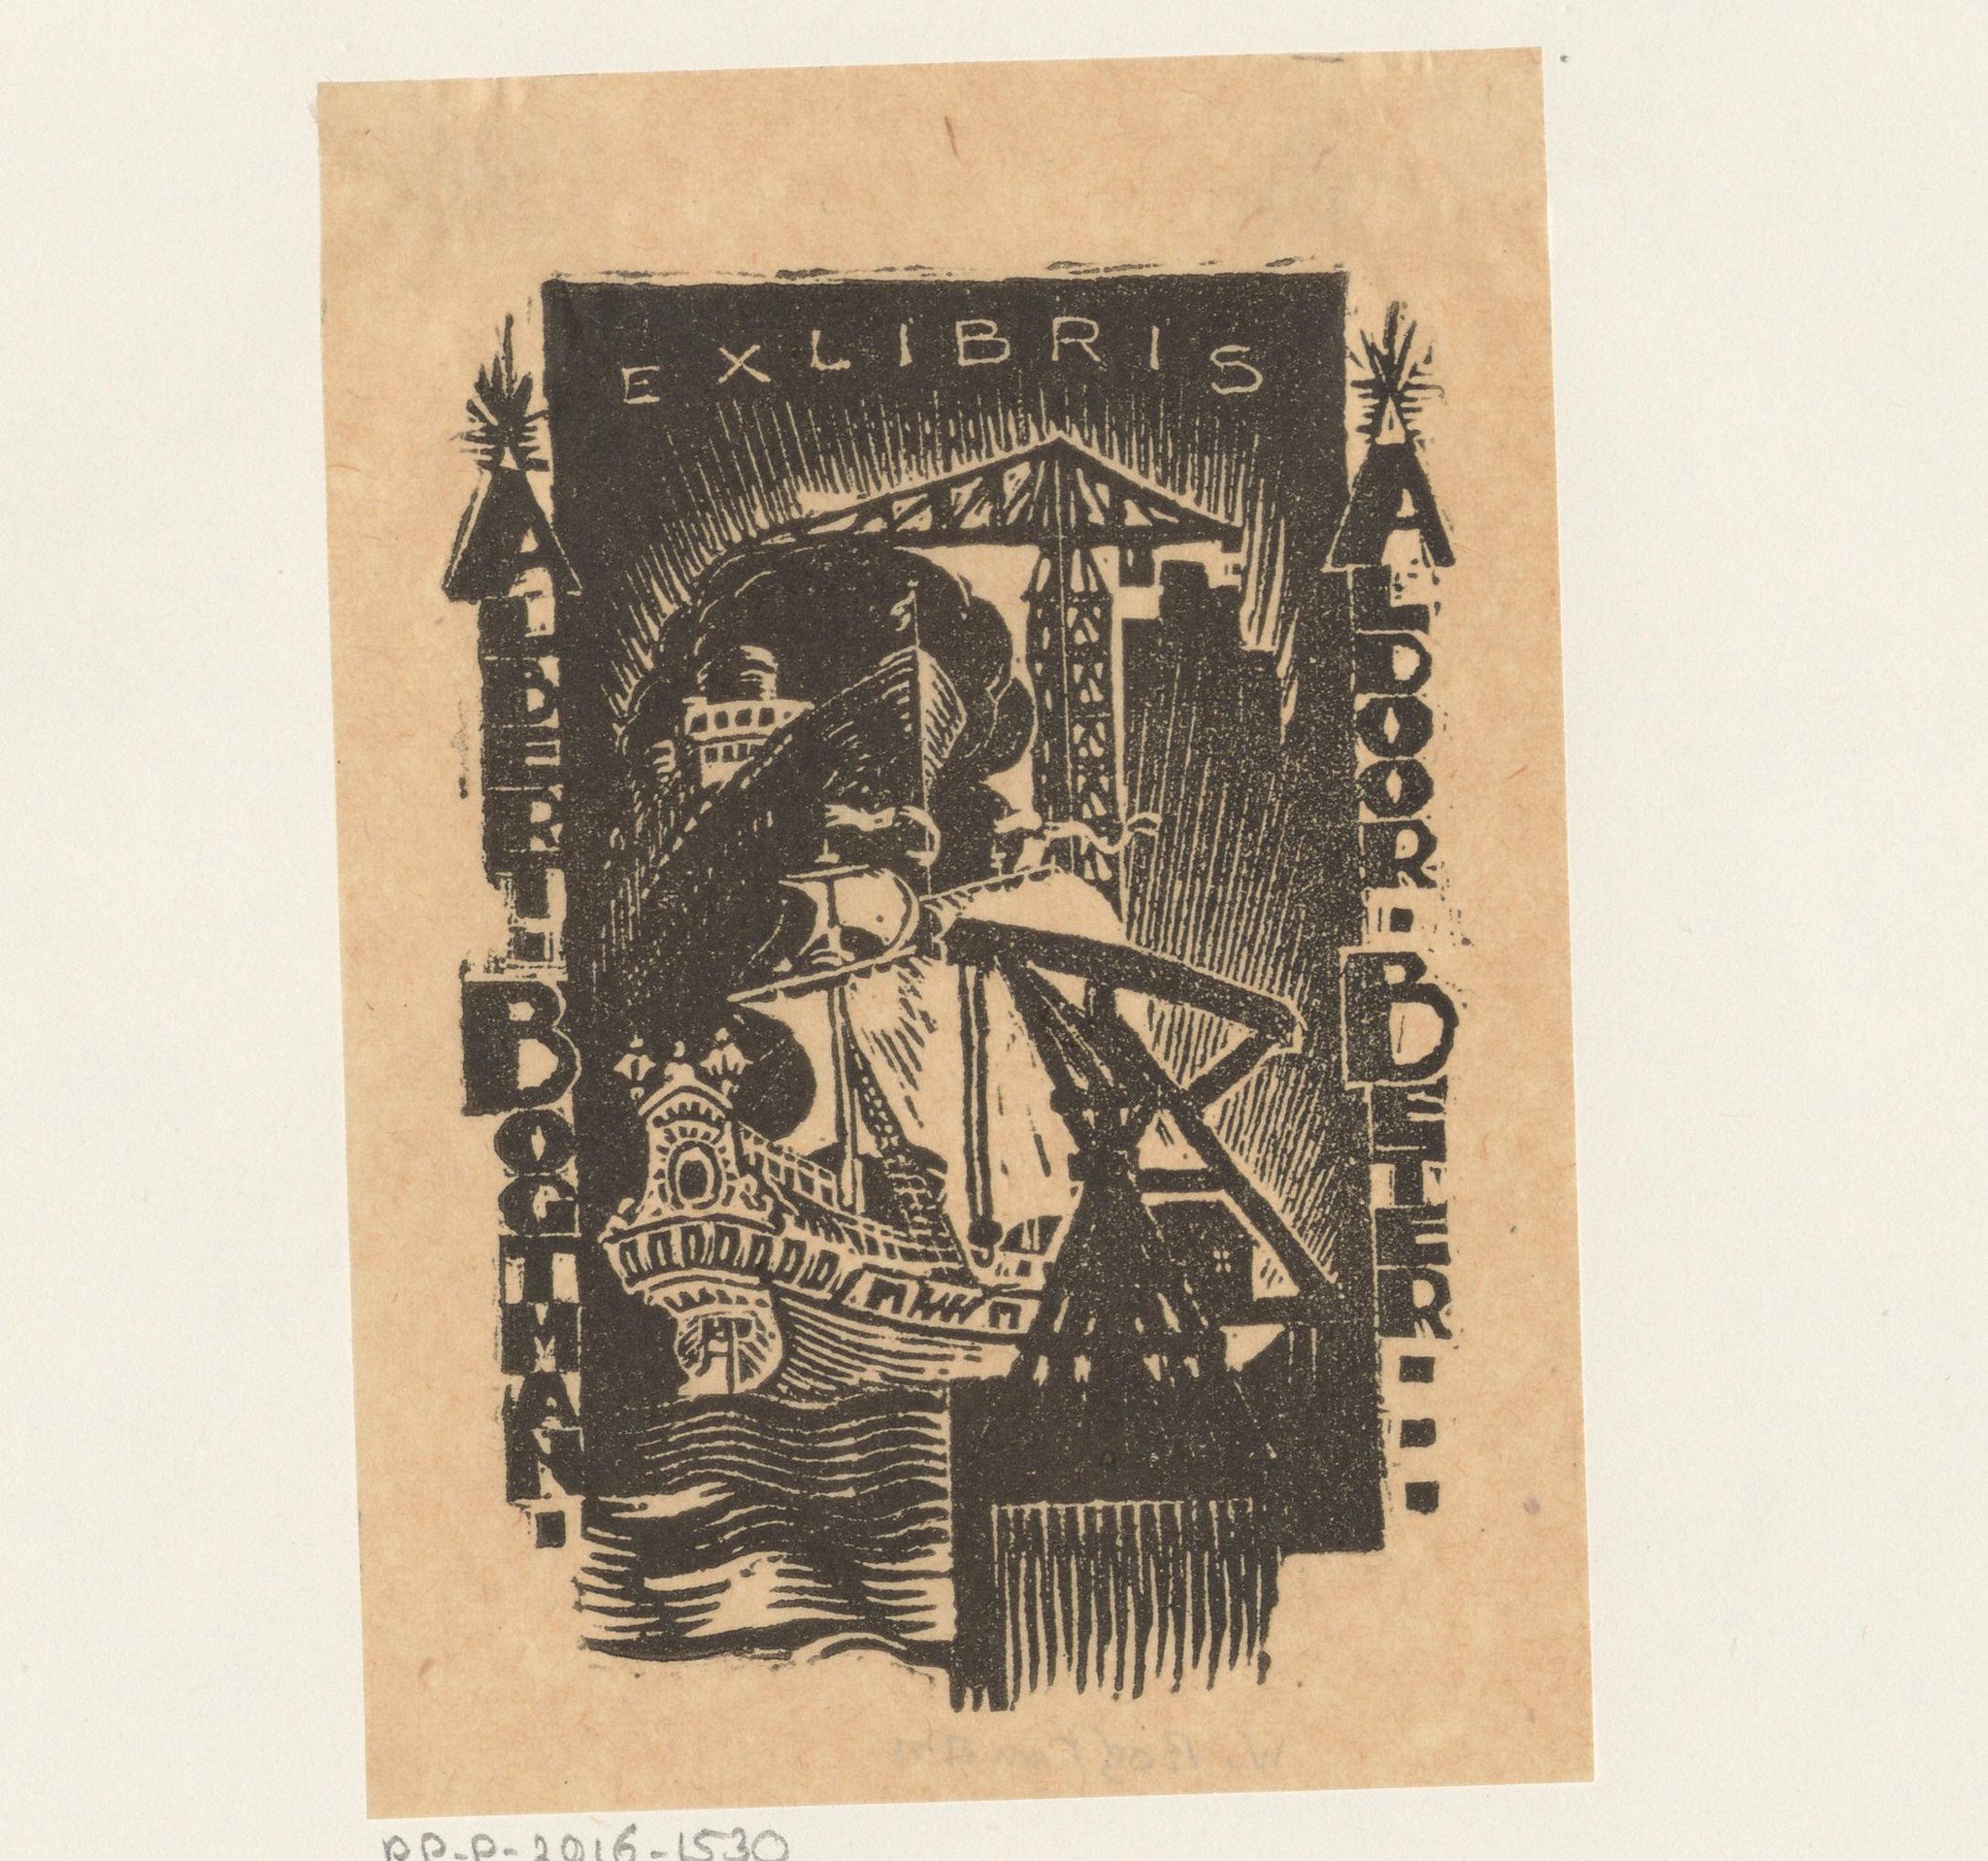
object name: bookplate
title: Ex libris van Albert Bogtman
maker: willem bogtman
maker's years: 1882-1955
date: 1892-1955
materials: paper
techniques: linocut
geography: netherlands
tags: harbour, ships (in general)